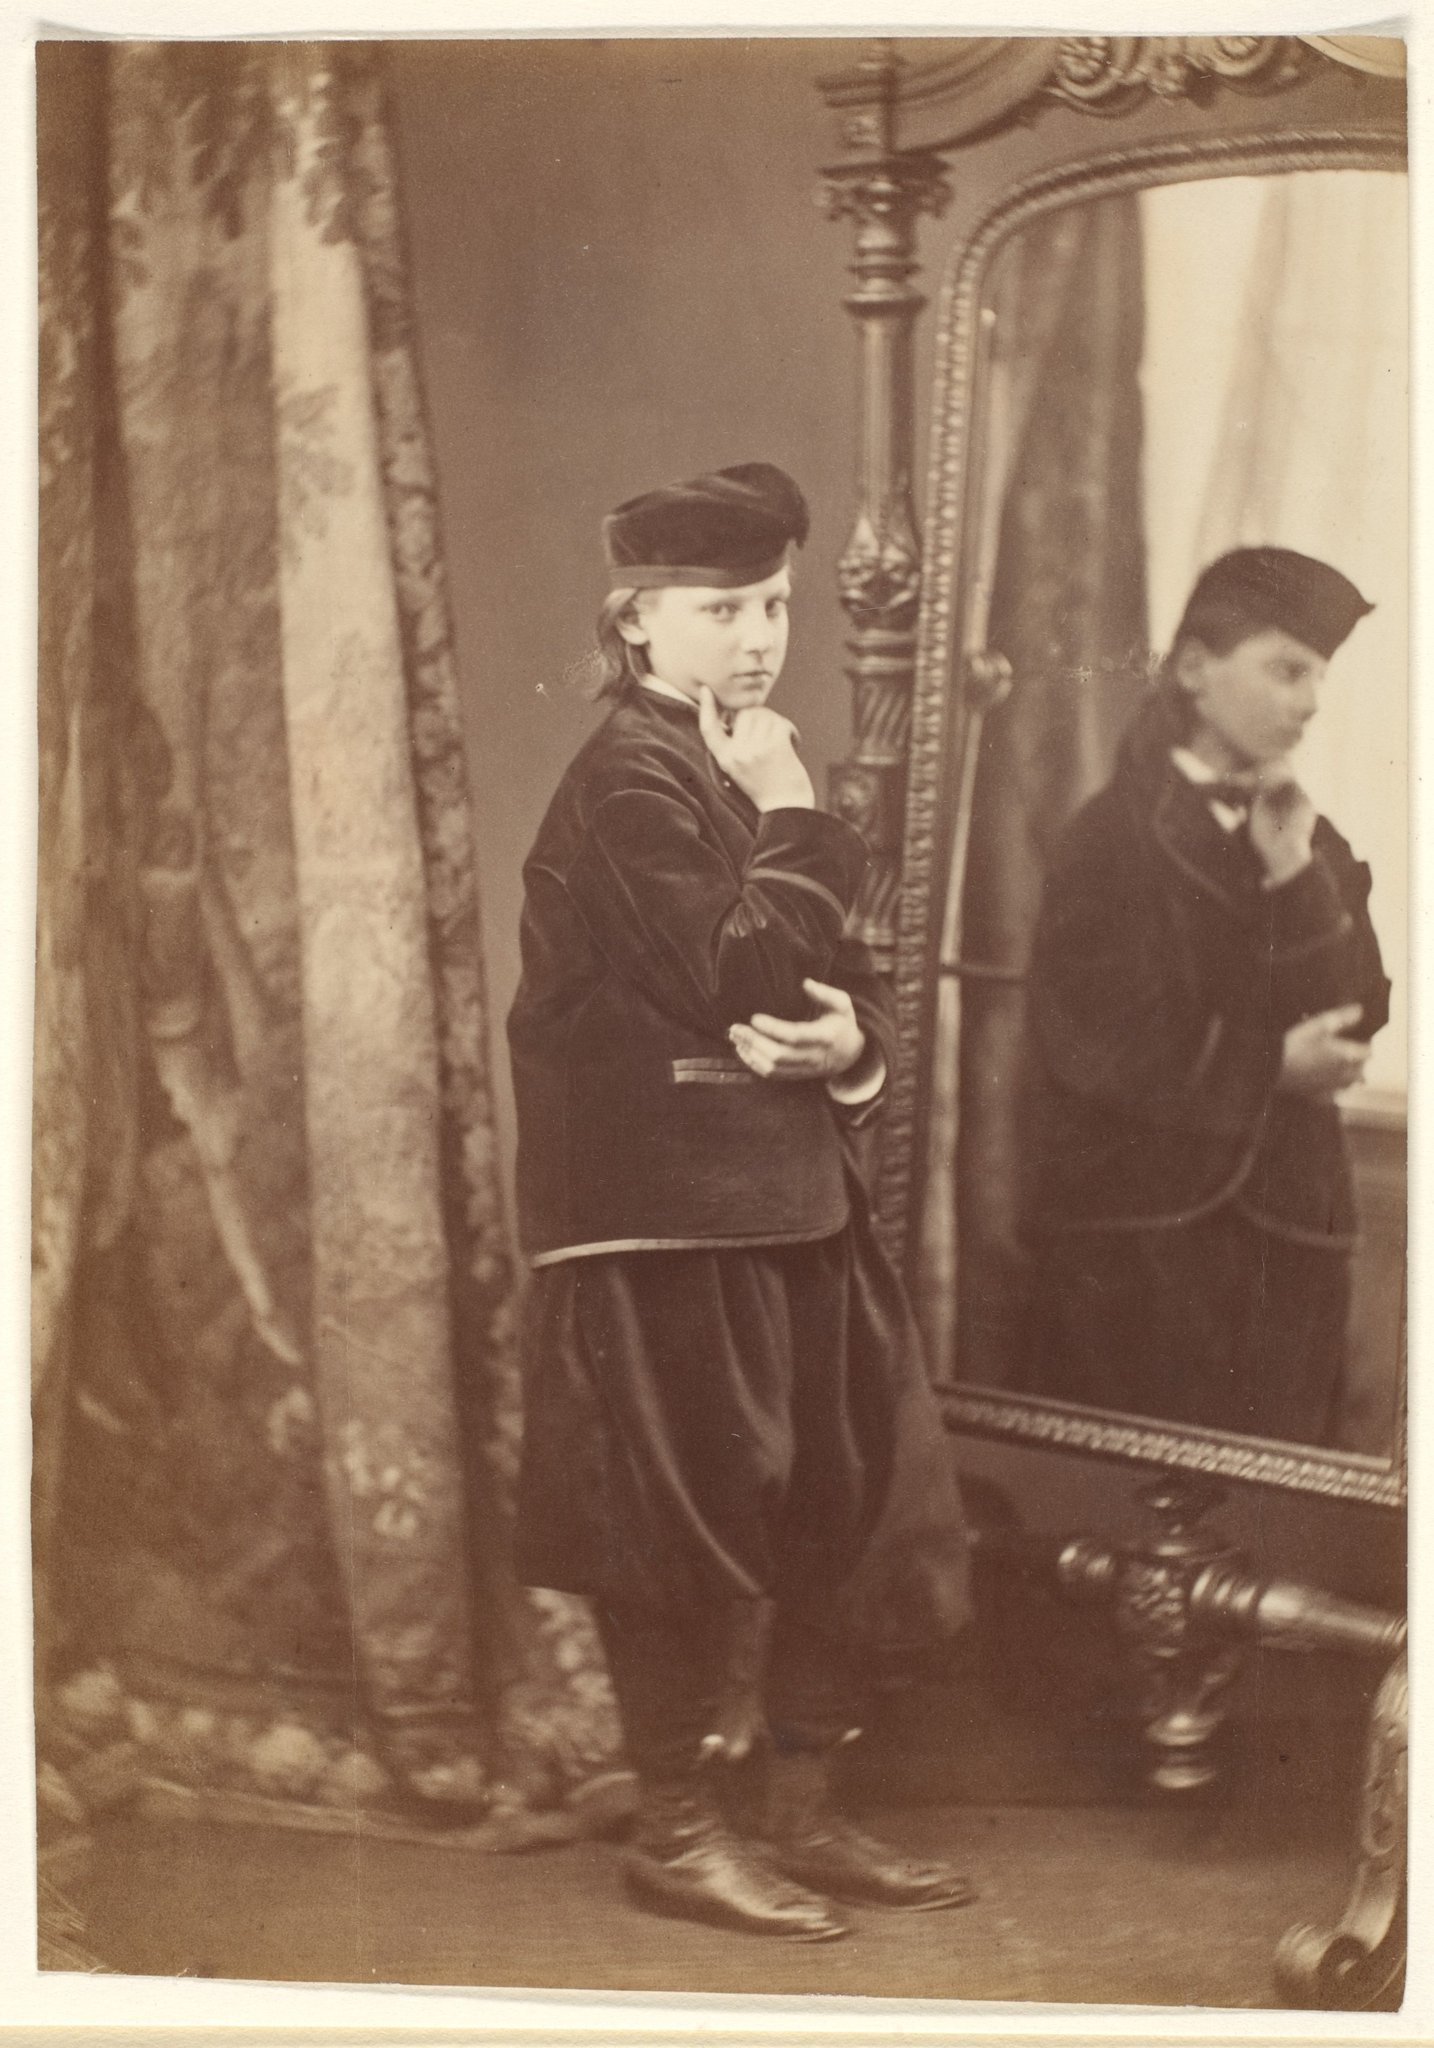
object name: photograph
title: Le petit Russe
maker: pierre-louis pierson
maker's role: artist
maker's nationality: french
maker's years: 1822-1913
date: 1860-1869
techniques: albumen silver print, glass negative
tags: boys,portraits,mirrors